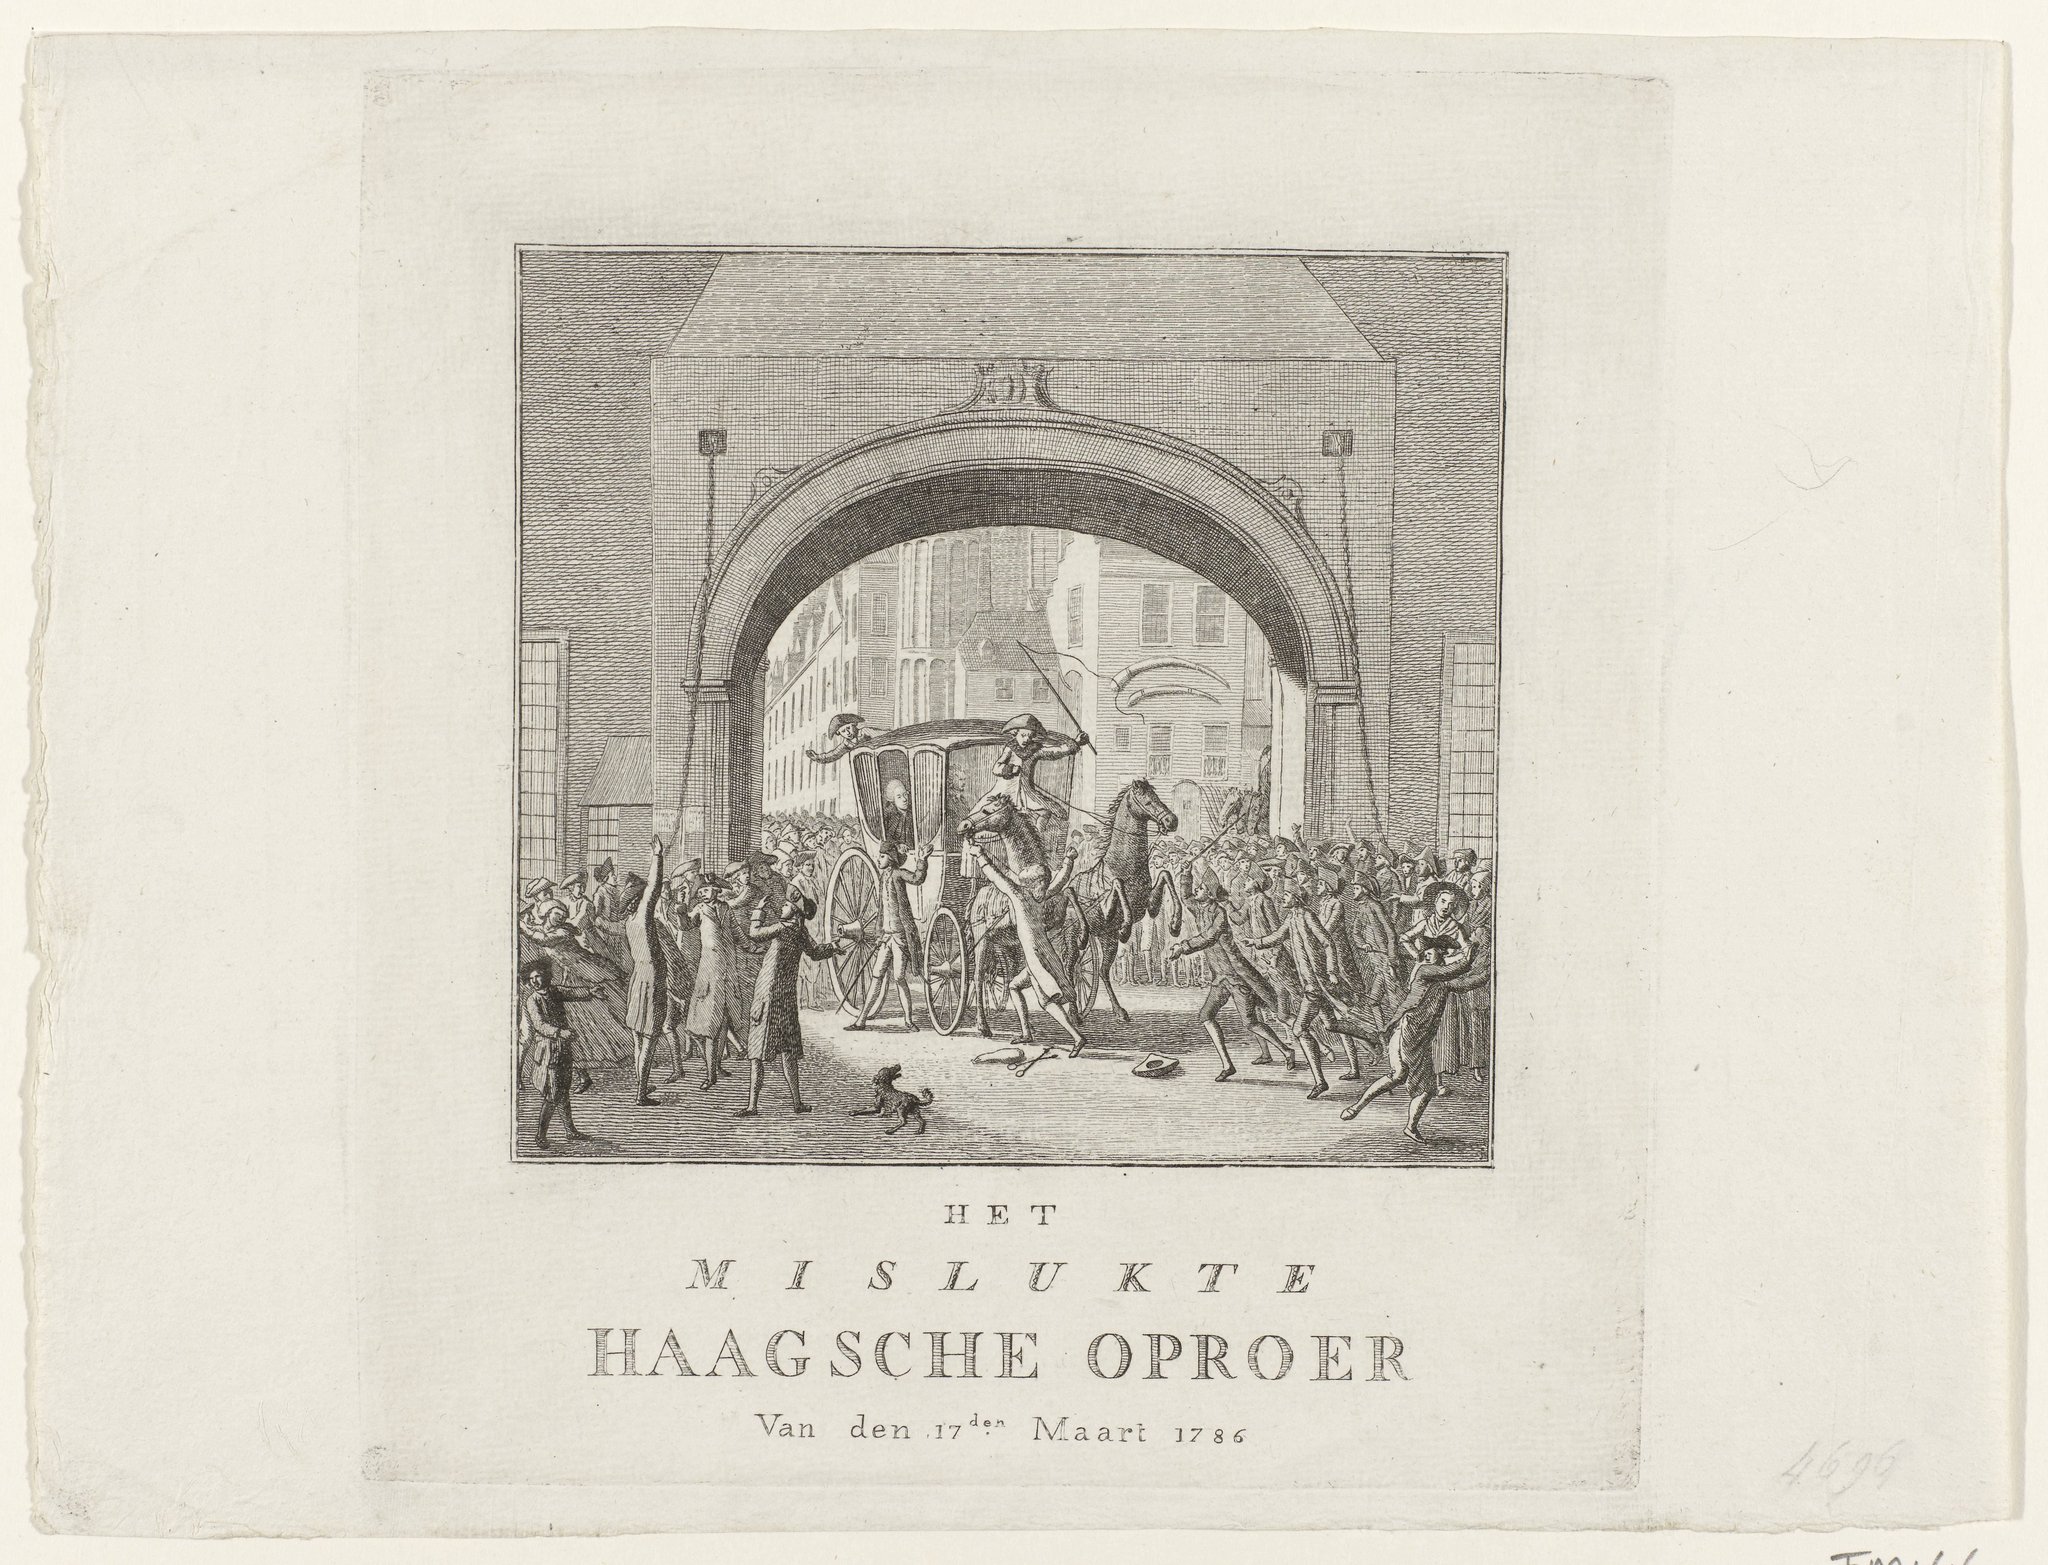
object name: print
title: Het Mislukte Haagsche Oproer Van den 17den Maart 1786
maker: Anonymous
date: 1786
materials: paper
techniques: engraving, etching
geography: northern netherlands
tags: revolutionary action (violent)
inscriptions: collector's mark: Lugt 2228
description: Ongeregeldheden als de gedeputeerden van Dordrecht, de heren Gevaerts en De Gijzelaar, met hun rijtuig door de Stadhouderspoort het Binnenhof op willen rijden en hun paarden bij de toom worden gegrepen door de Haagse pruikenmaker F. Mourand, 17 maart 1786.